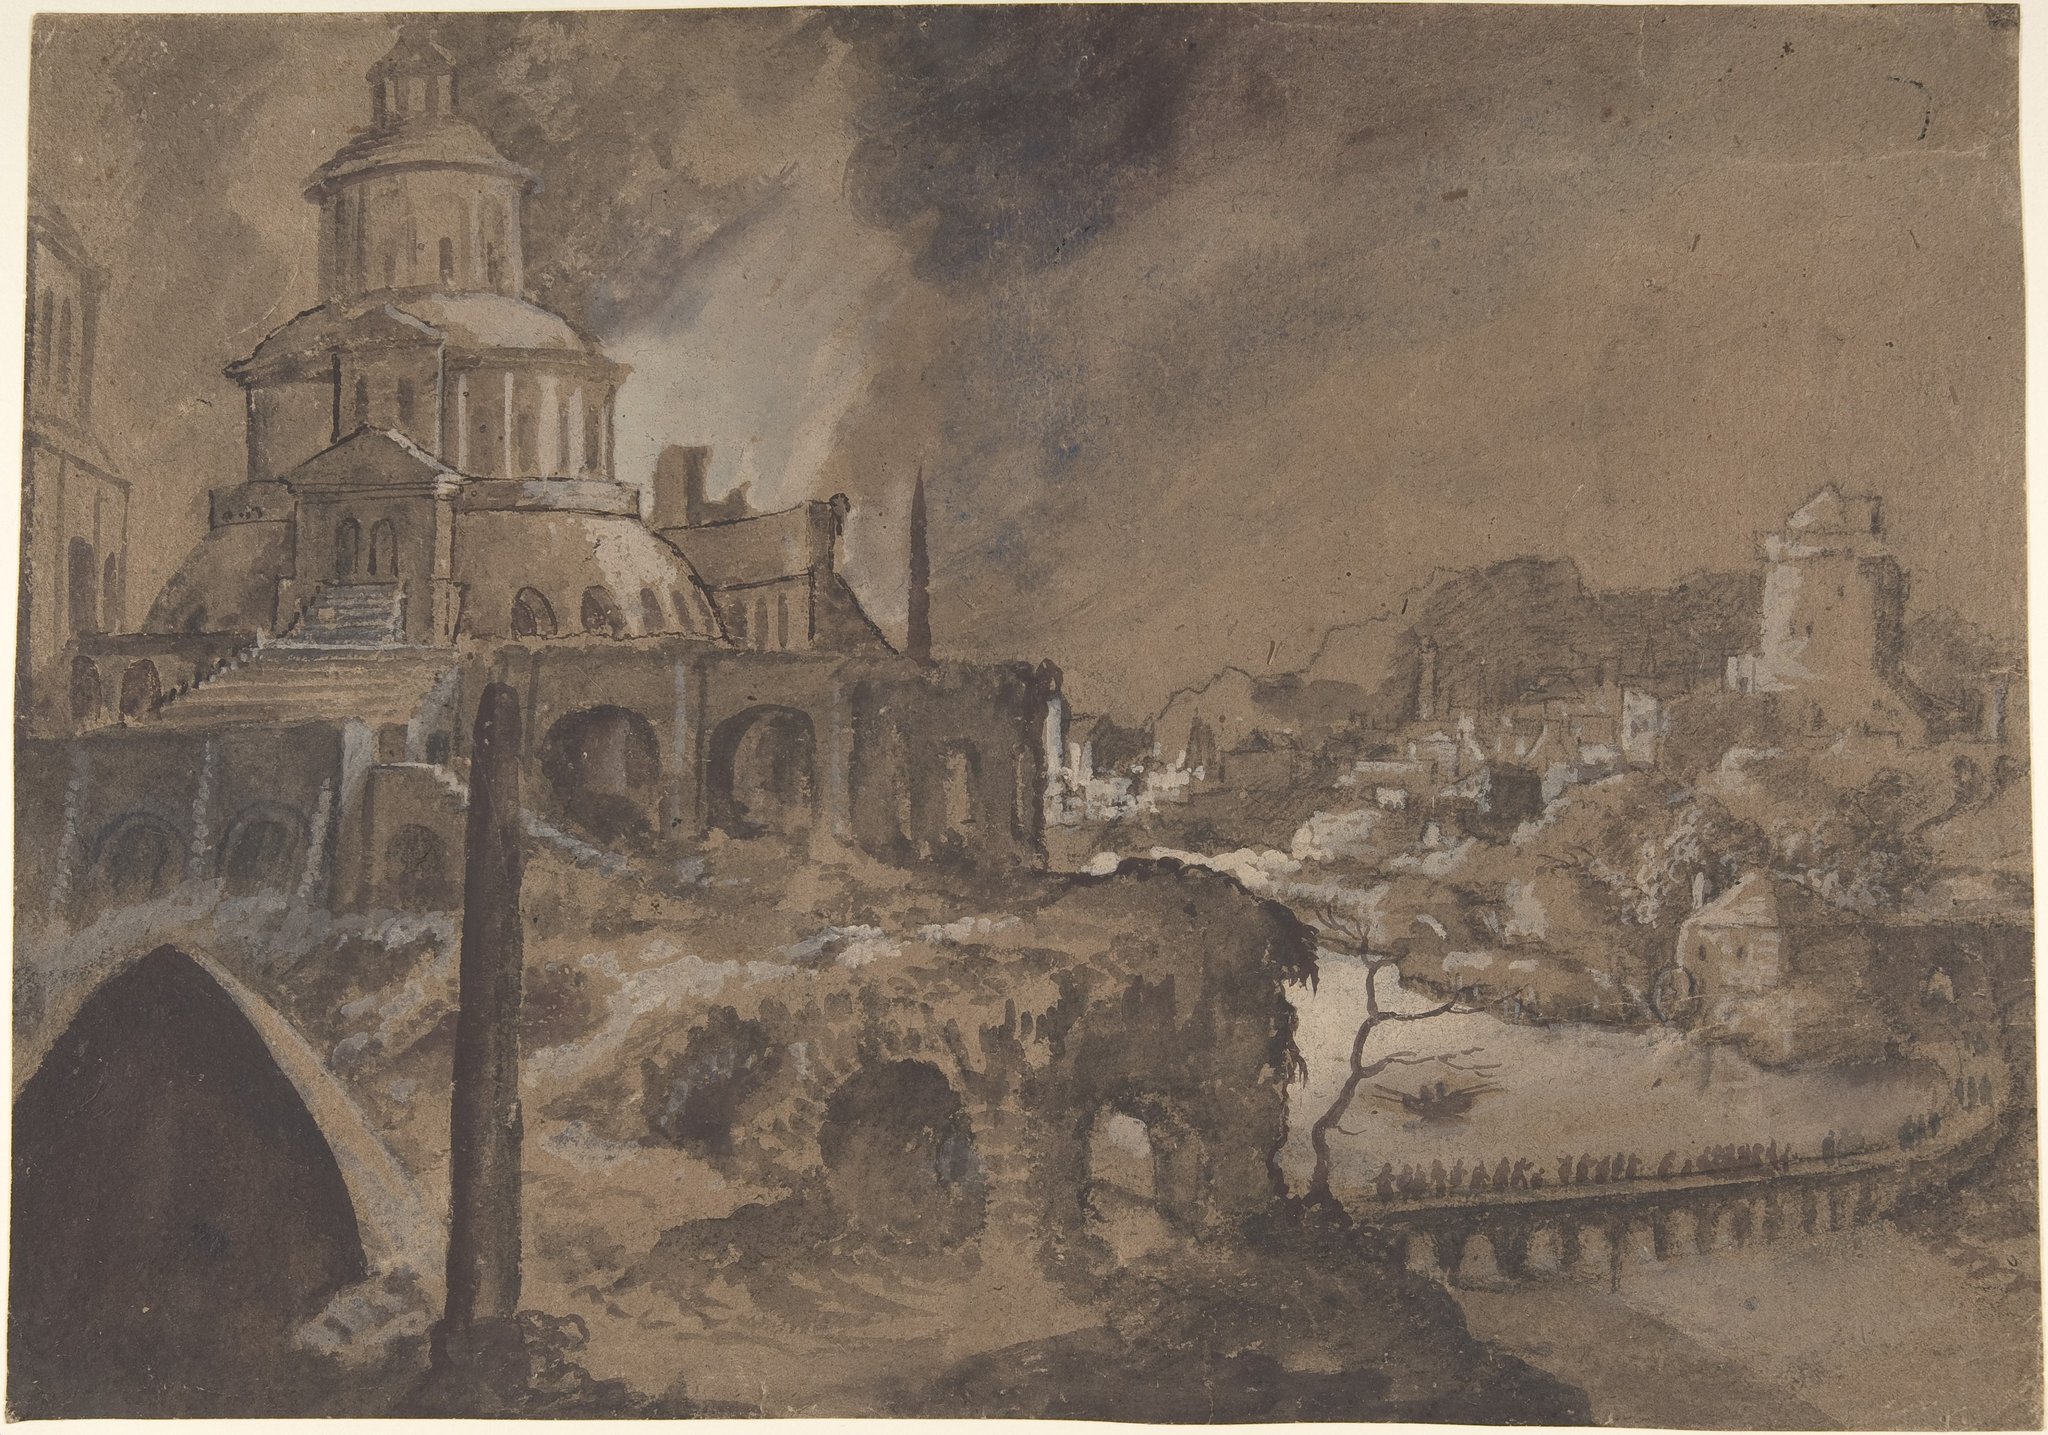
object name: drawing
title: Fantastic Landscape with Figures Crossing a Bridge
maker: lancelot blondeel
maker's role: draughtsman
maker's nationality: flemish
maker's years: 1498-1561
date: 1501-1600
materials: chalk, paper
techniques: brush, heightening, wash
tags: buildings,bridges,landscapes